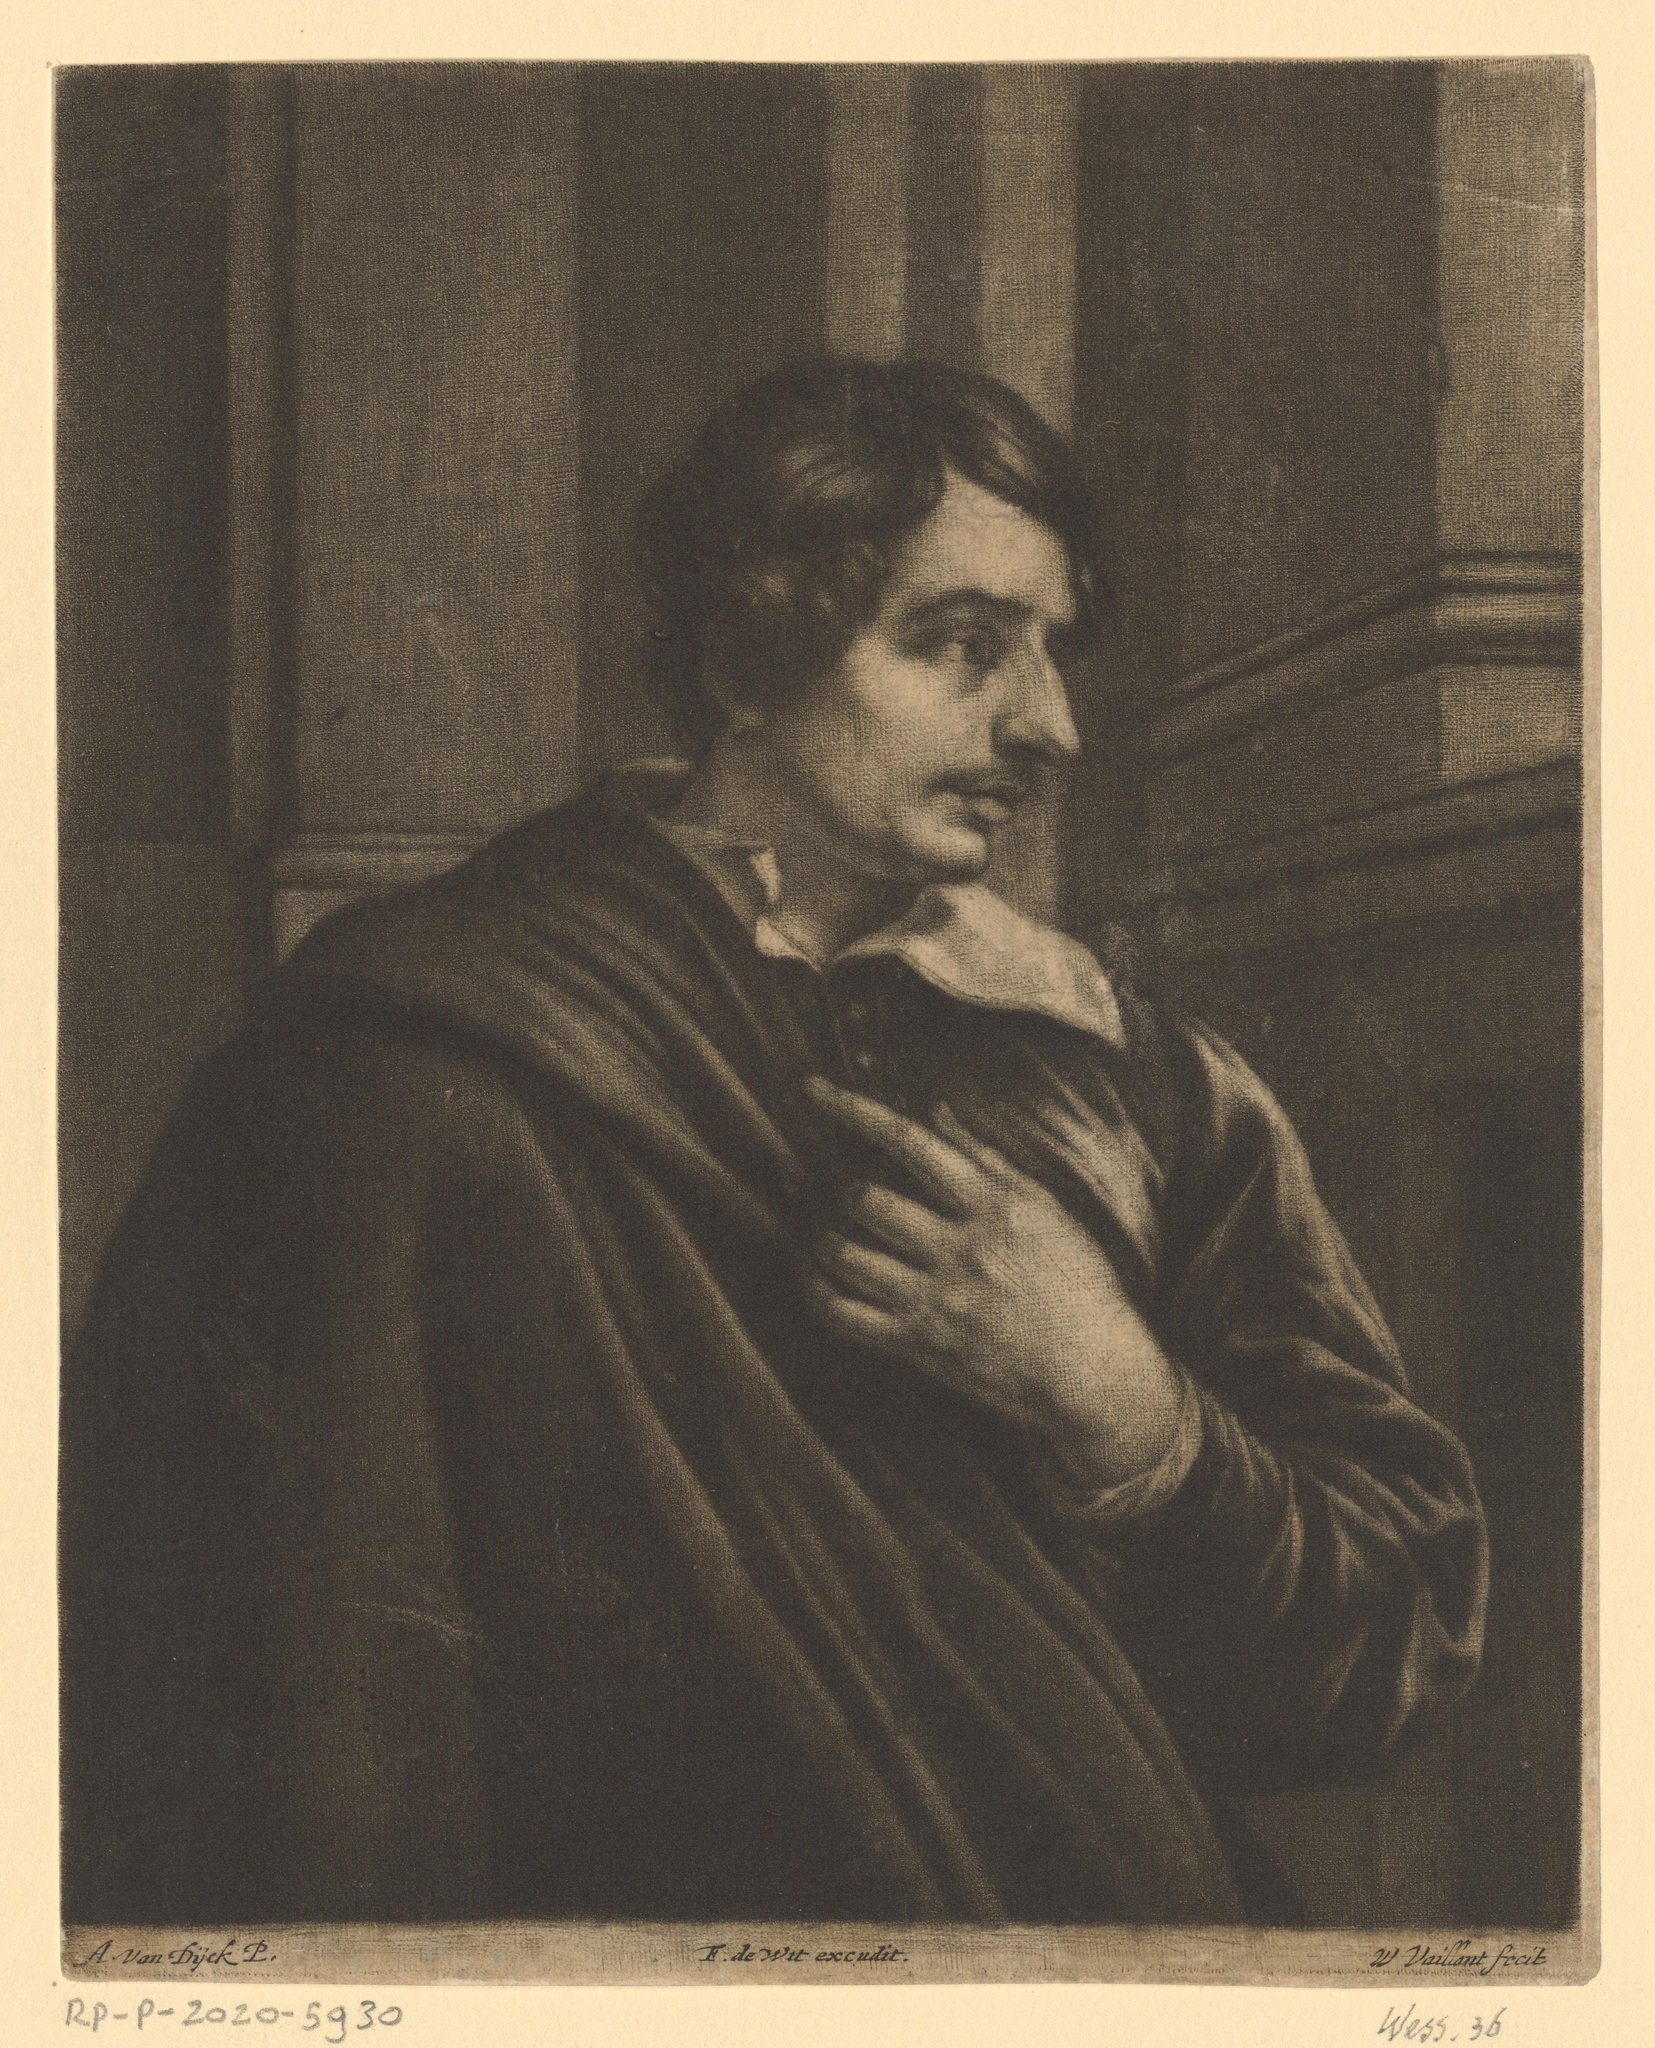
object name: print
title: Portret van een man, mogelijk de kunstenaar Jean Leclerc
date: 1669-1706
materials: paper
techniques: mezzotint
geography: amsterdam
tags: print maker, jean leclerc, historical persons, portrait, self-portrait of painter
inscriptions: inscription: ‘IV93 /N[]’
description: Op een ander exemplaar van deze prent staat de naam van Jean Leclerc geschreven, zie RP-P-1910-6846 .